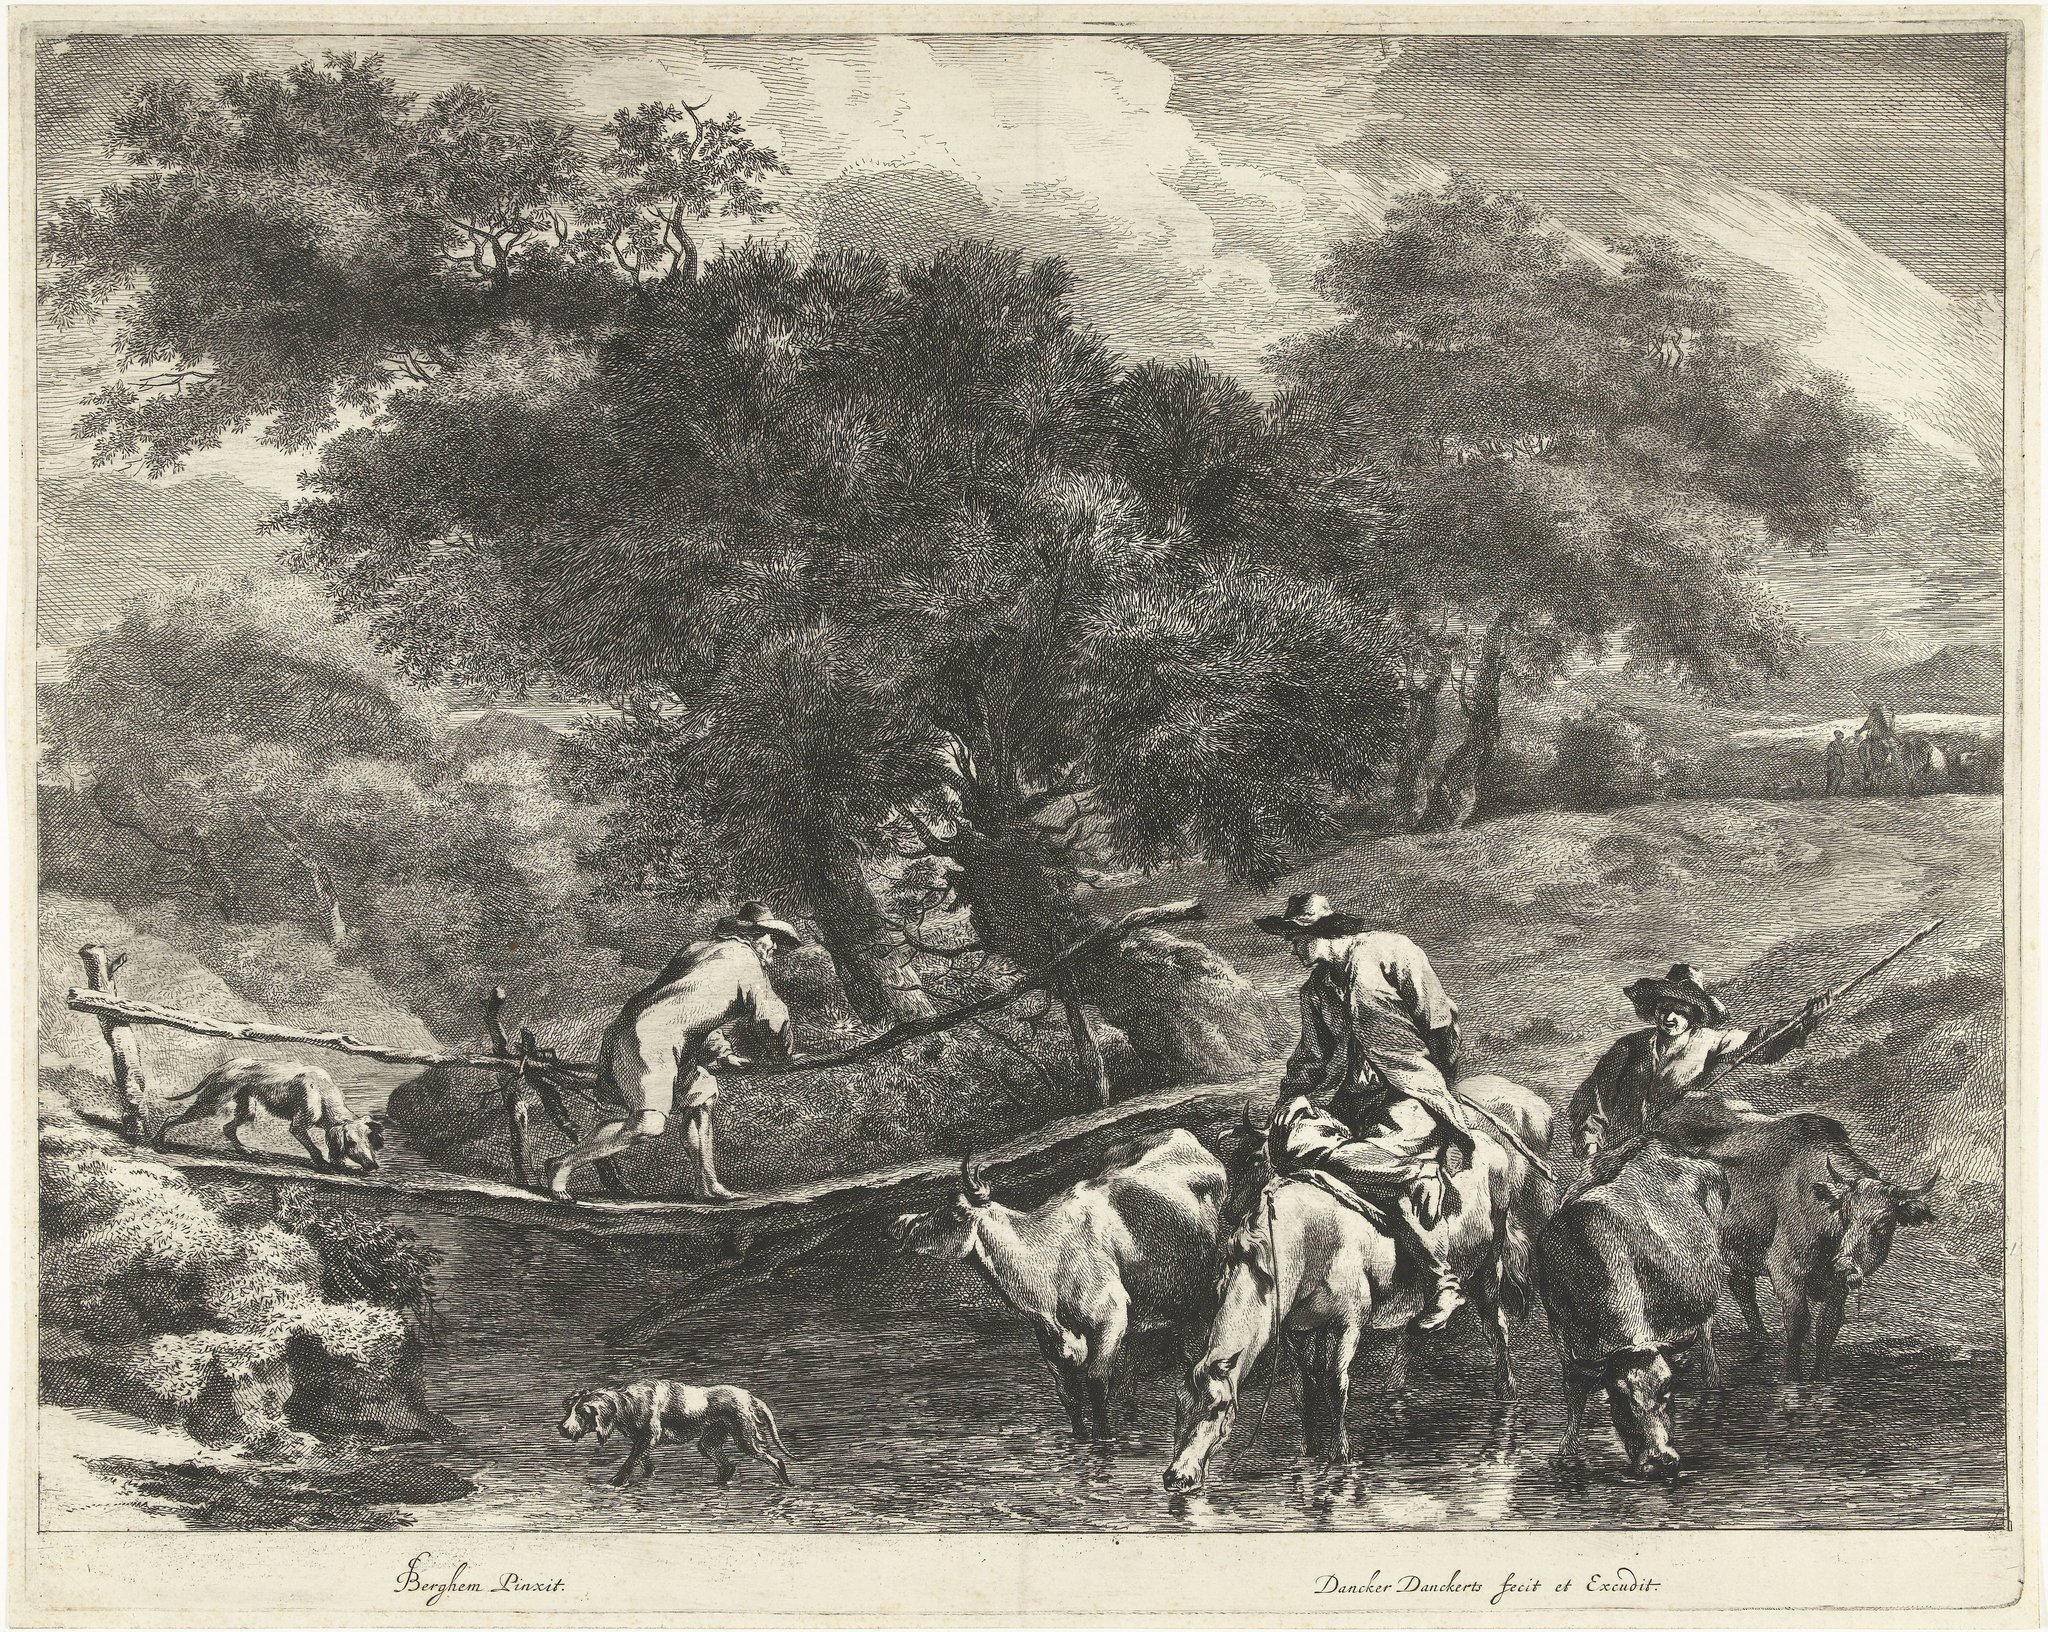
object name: print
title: Tijden van de dag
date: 1660-1666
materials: paper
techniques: etching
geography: amsterdam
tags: herding, herdsman, herdswoman, shepherd, shepherdess, cowherd, etc., landscape with bridge, viaduct or aqueduct, morning ~ other concepts, rocks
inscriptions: collector's mark: Lugt 240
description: Man met hond loopt op voetbrug en passeert ruiter en herder met kudde koeien die drinken bij het ondiepe water. Prent nummer 1 uit serie van vier prenten met tijden van de dag.